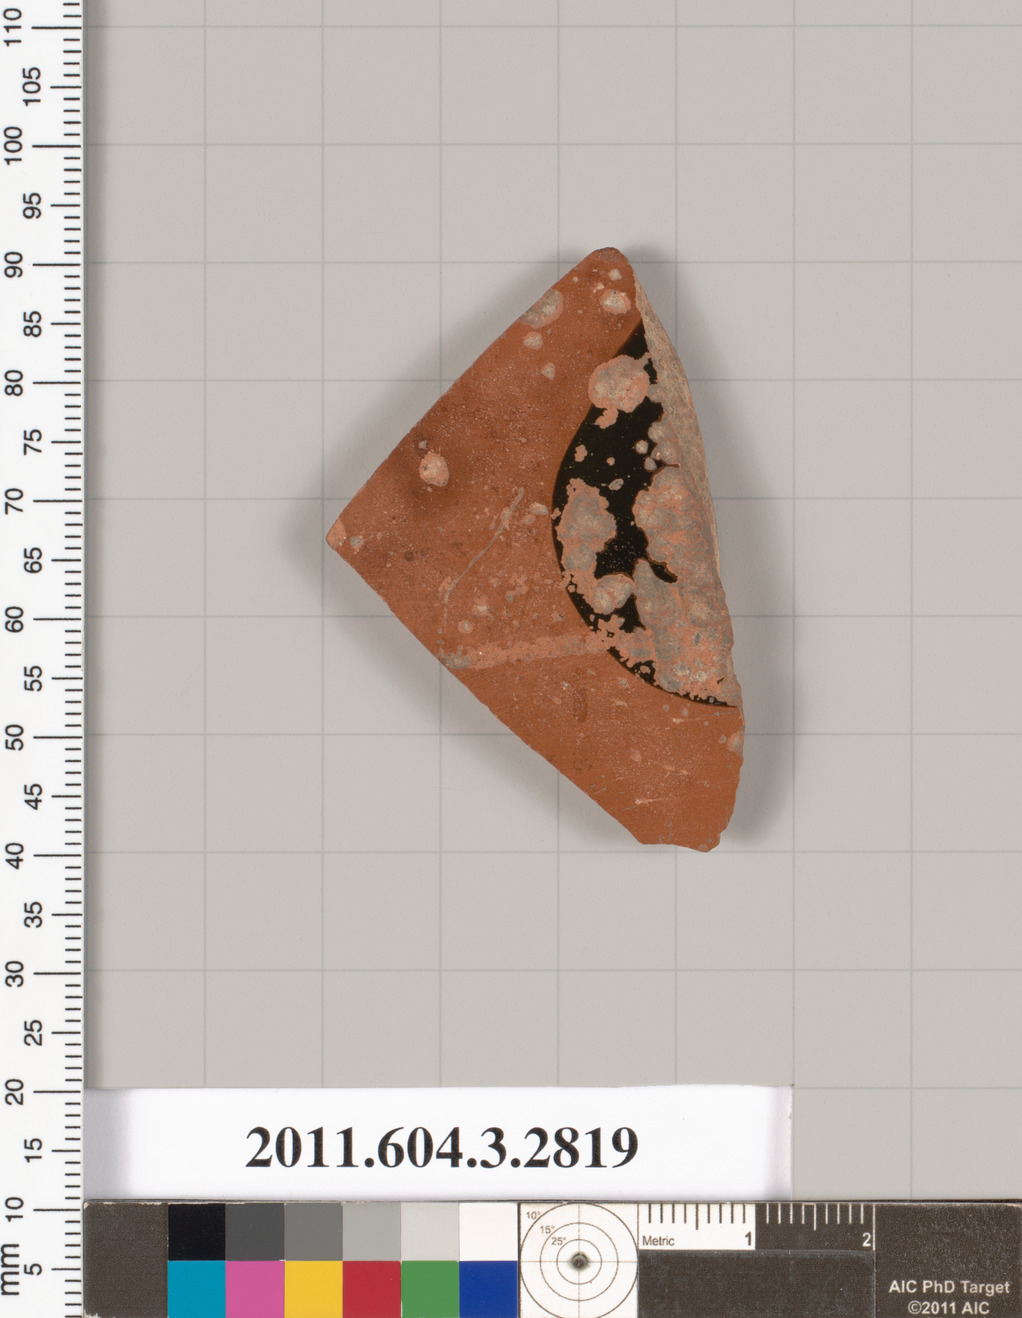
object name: undetermined shape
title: Terracotta fragment of an undetermined shape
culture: greek, attic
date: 600-401 BCE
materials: terracotta